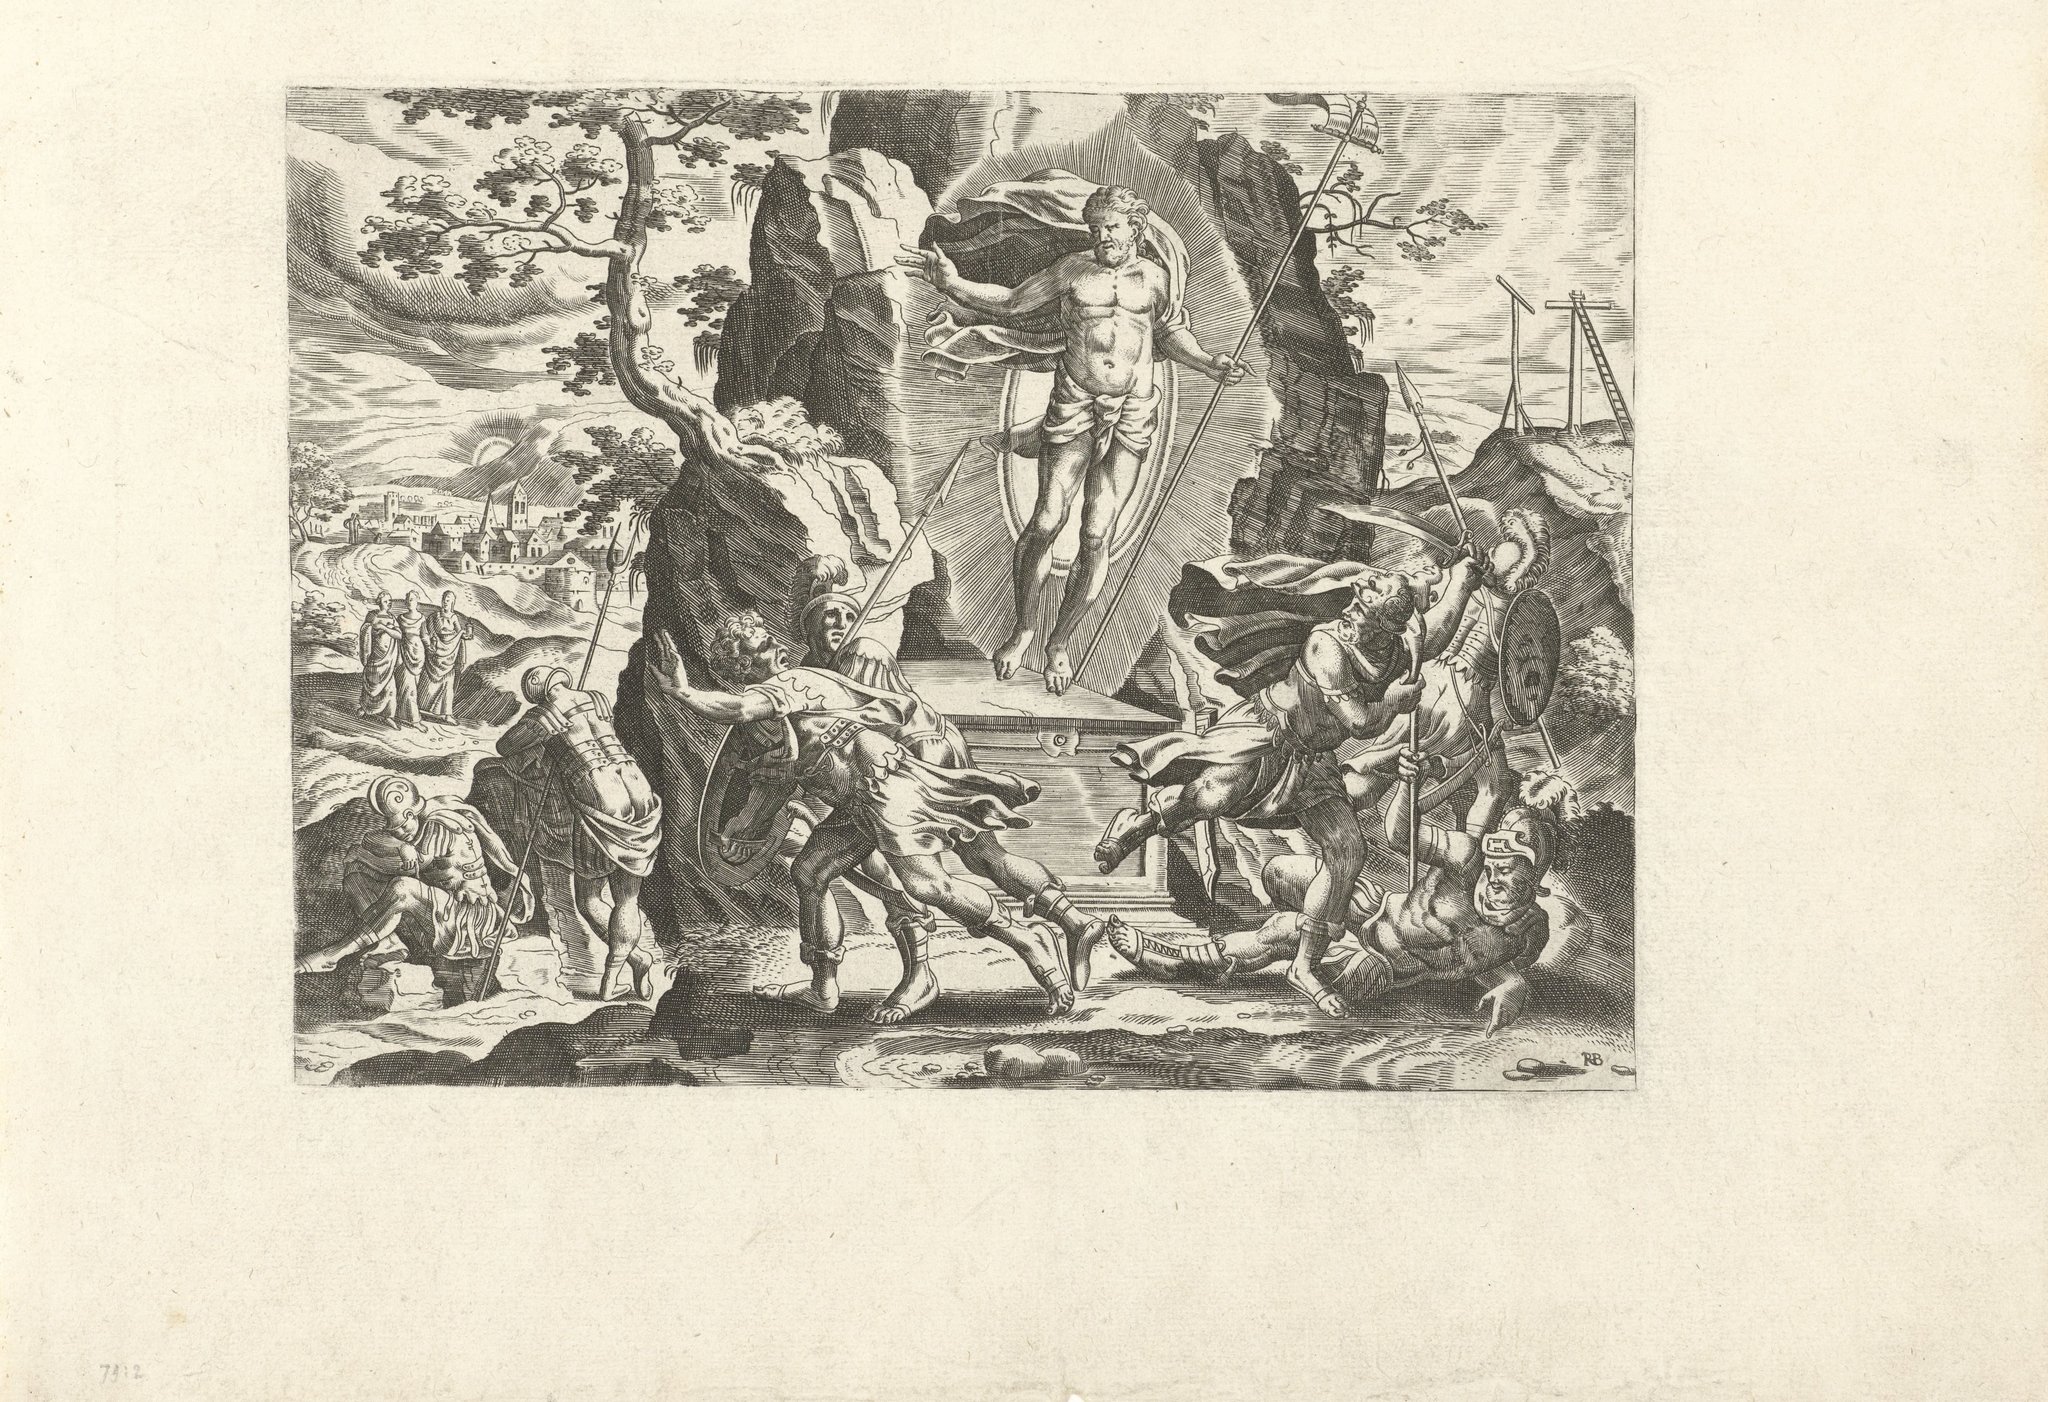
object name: print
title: Opstanding van Christus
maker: remigius hogenberg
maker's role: print maker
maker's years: 1536-1587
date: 1546-1588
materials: paper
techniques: engraving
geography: southern netherlands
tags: christ, usually holding a banner, arises from the grave; often combined with sleeping and/or frightened soldiers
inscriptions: collector's mark: Lugt 2760, collector's mark: Lugt 2228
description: Christus boven een sarcofaag, de banier van de Opstanding in zijn hand. Op de voorgrond wegvluchtende soldaten. Links op de achtergrond de drie vrouwen waaronder Maria Magdalena met in haar hand haar zalfpot. Rechts op de achtergrond Golgotha.